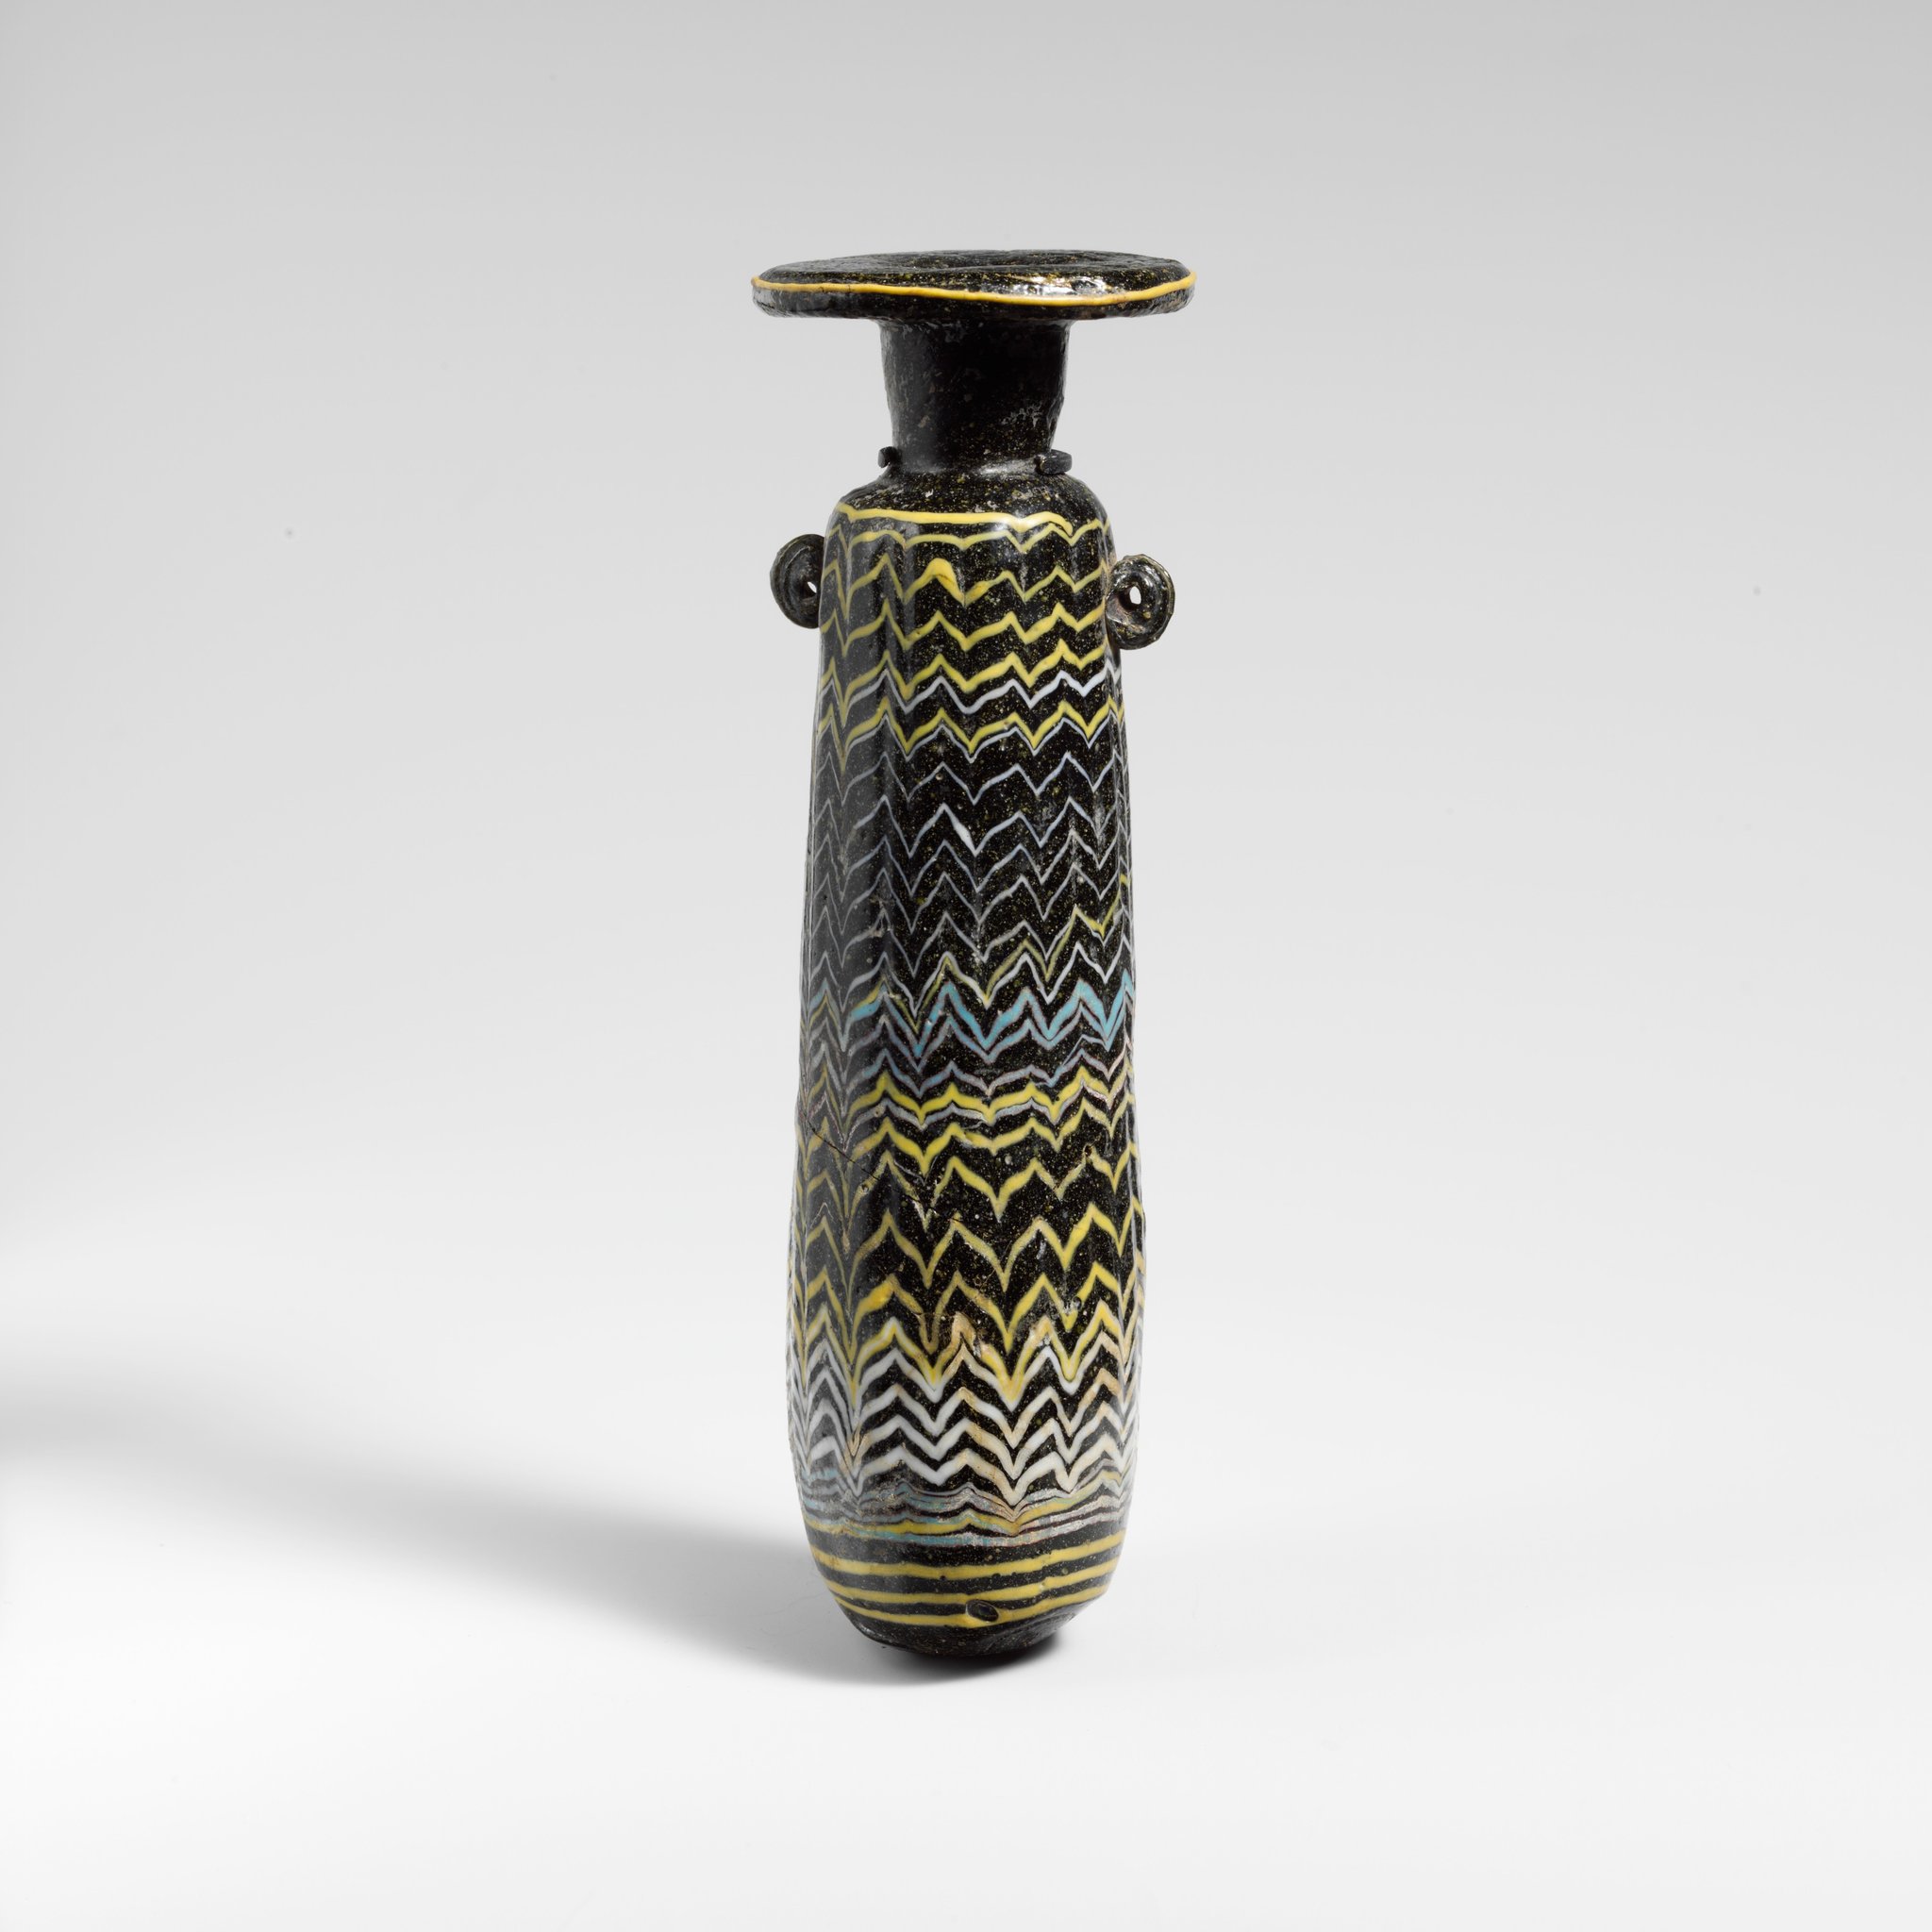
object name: alabastron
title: Glass alabastron (perfume bottle)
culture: eastern mediterranean or italian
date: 334-268 BCE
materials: glass